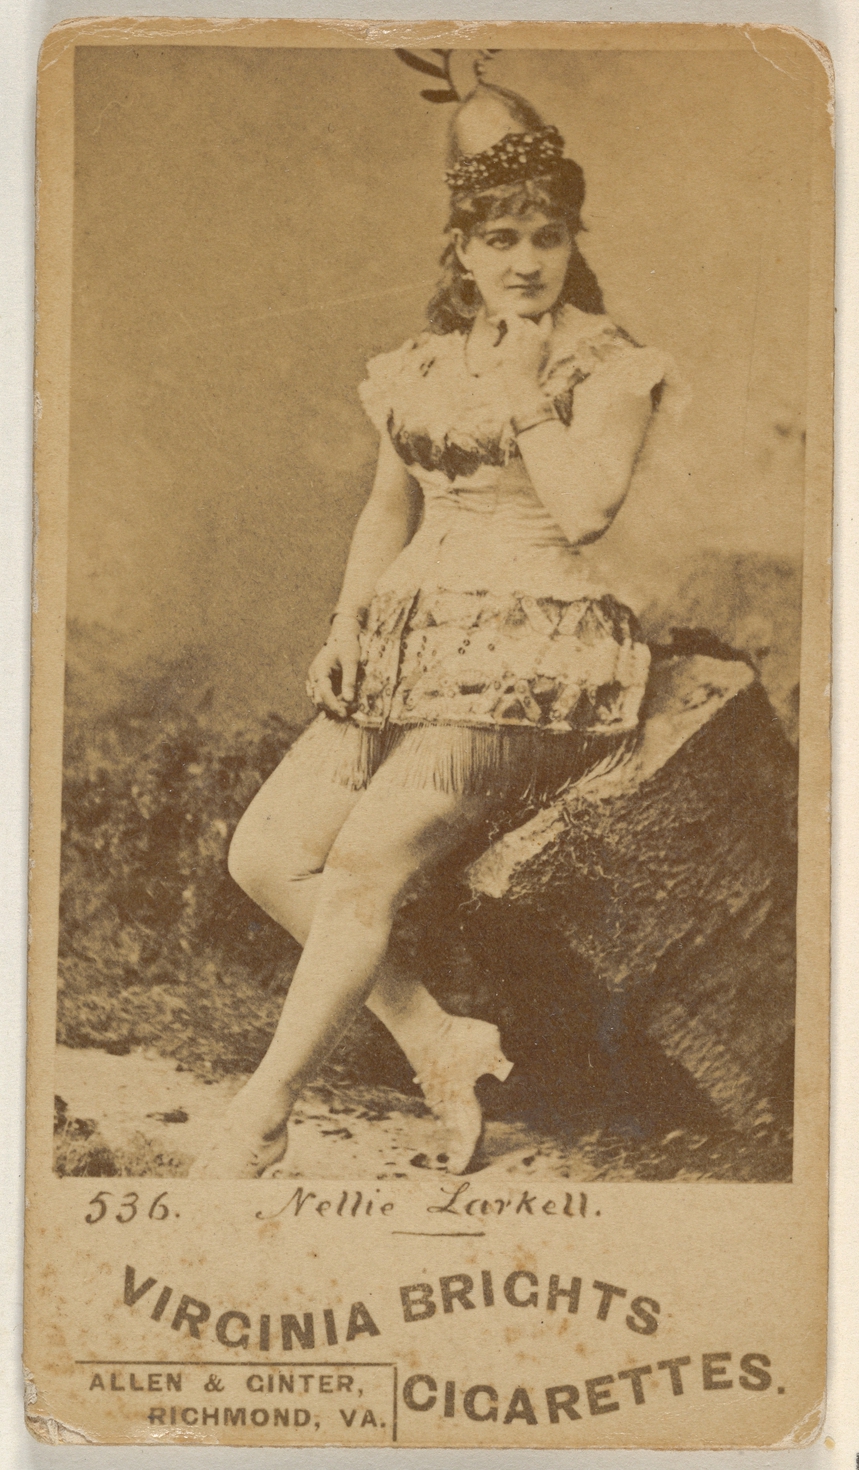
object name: photograph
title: Card 536, Nellie Larkell, from the Actors and Actresses series (N45, Type 6) for Virginia Brights Cigarettes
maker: allen & ginter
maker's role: publisher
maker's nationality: american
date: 1888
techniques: albumen silver print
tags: portraits,women,actresses